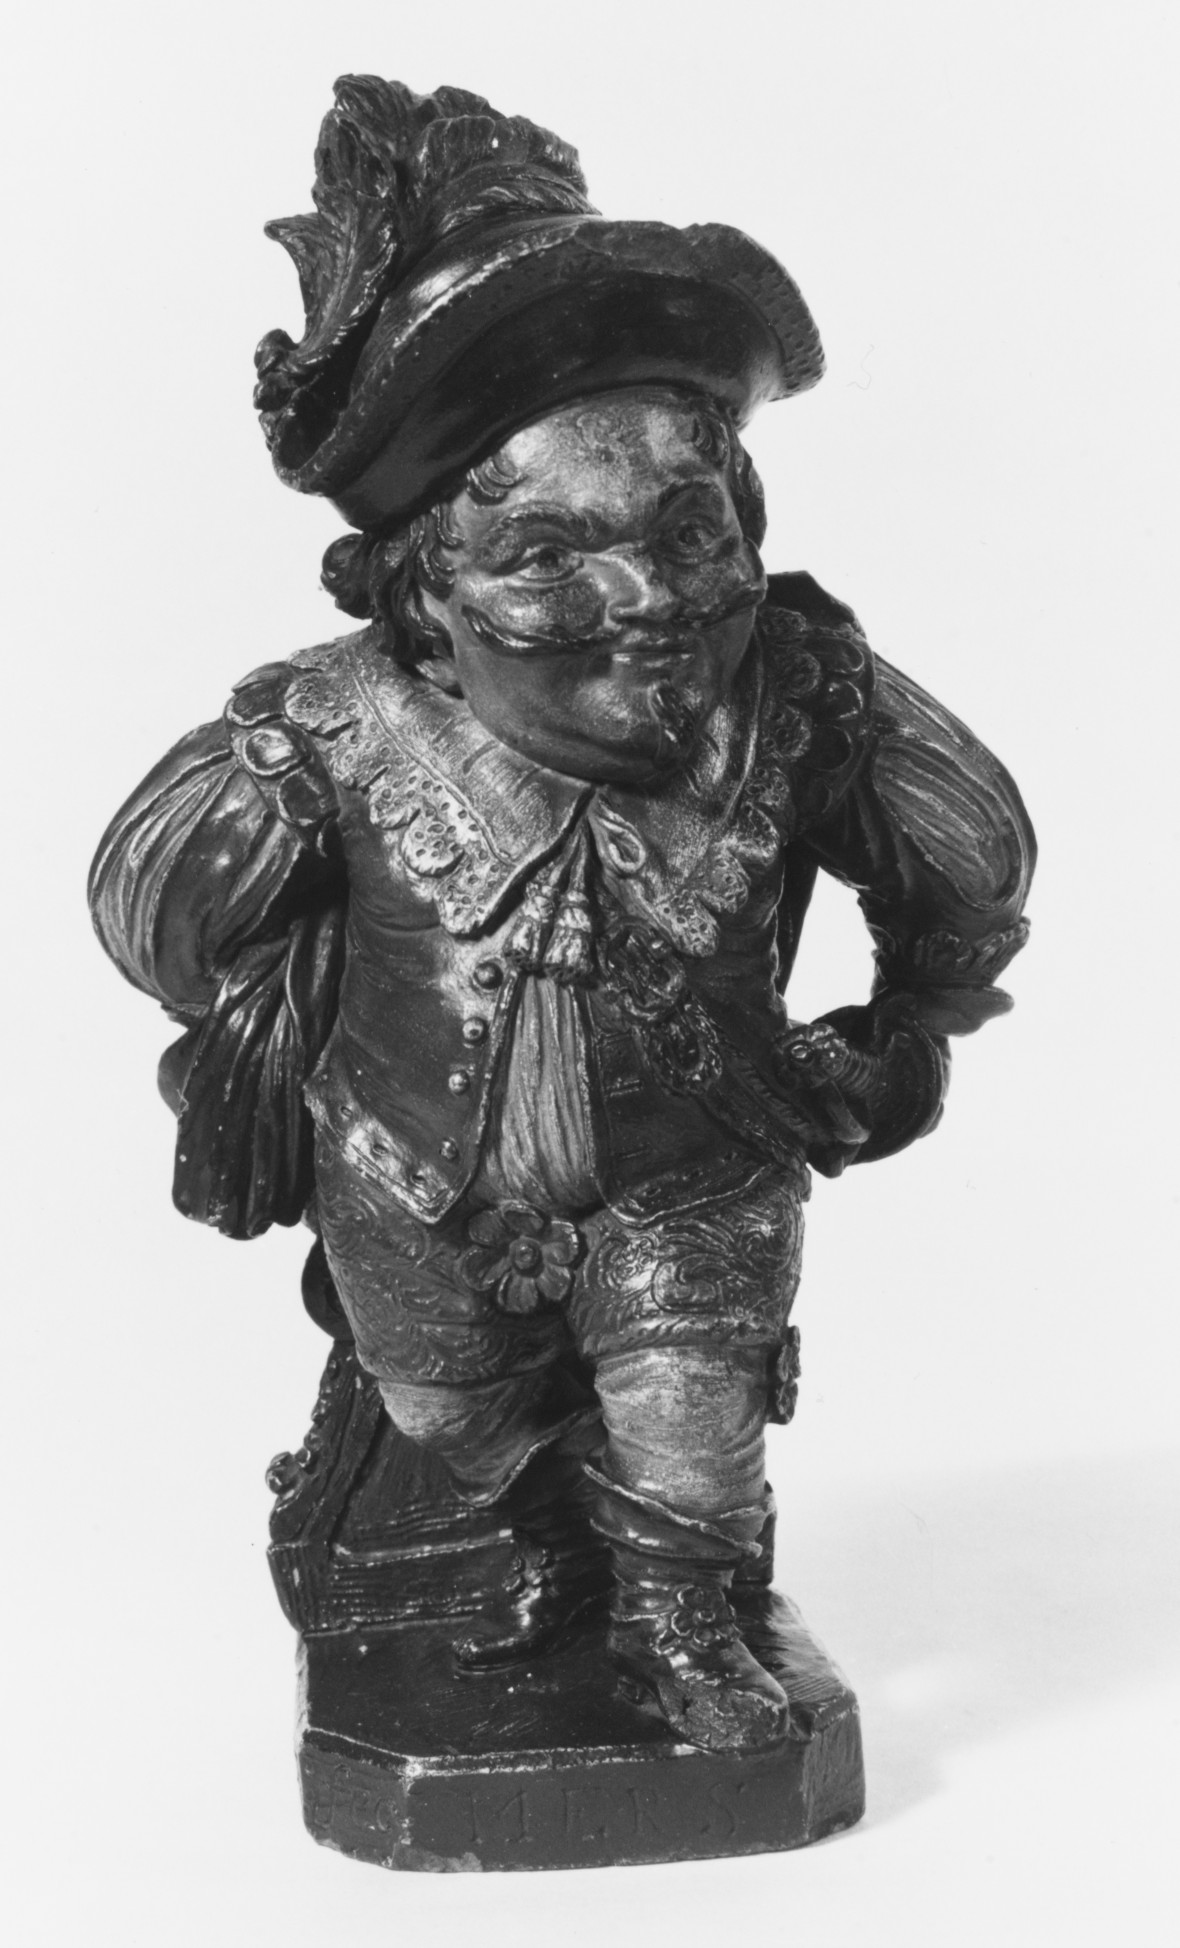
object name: statuette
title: Dwarf as Mars (one of a pair)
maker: walter pompe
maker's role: artist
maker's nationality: flemish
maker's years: 1703-1777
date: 1770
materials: terracotta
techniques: casting, polychrome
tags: men